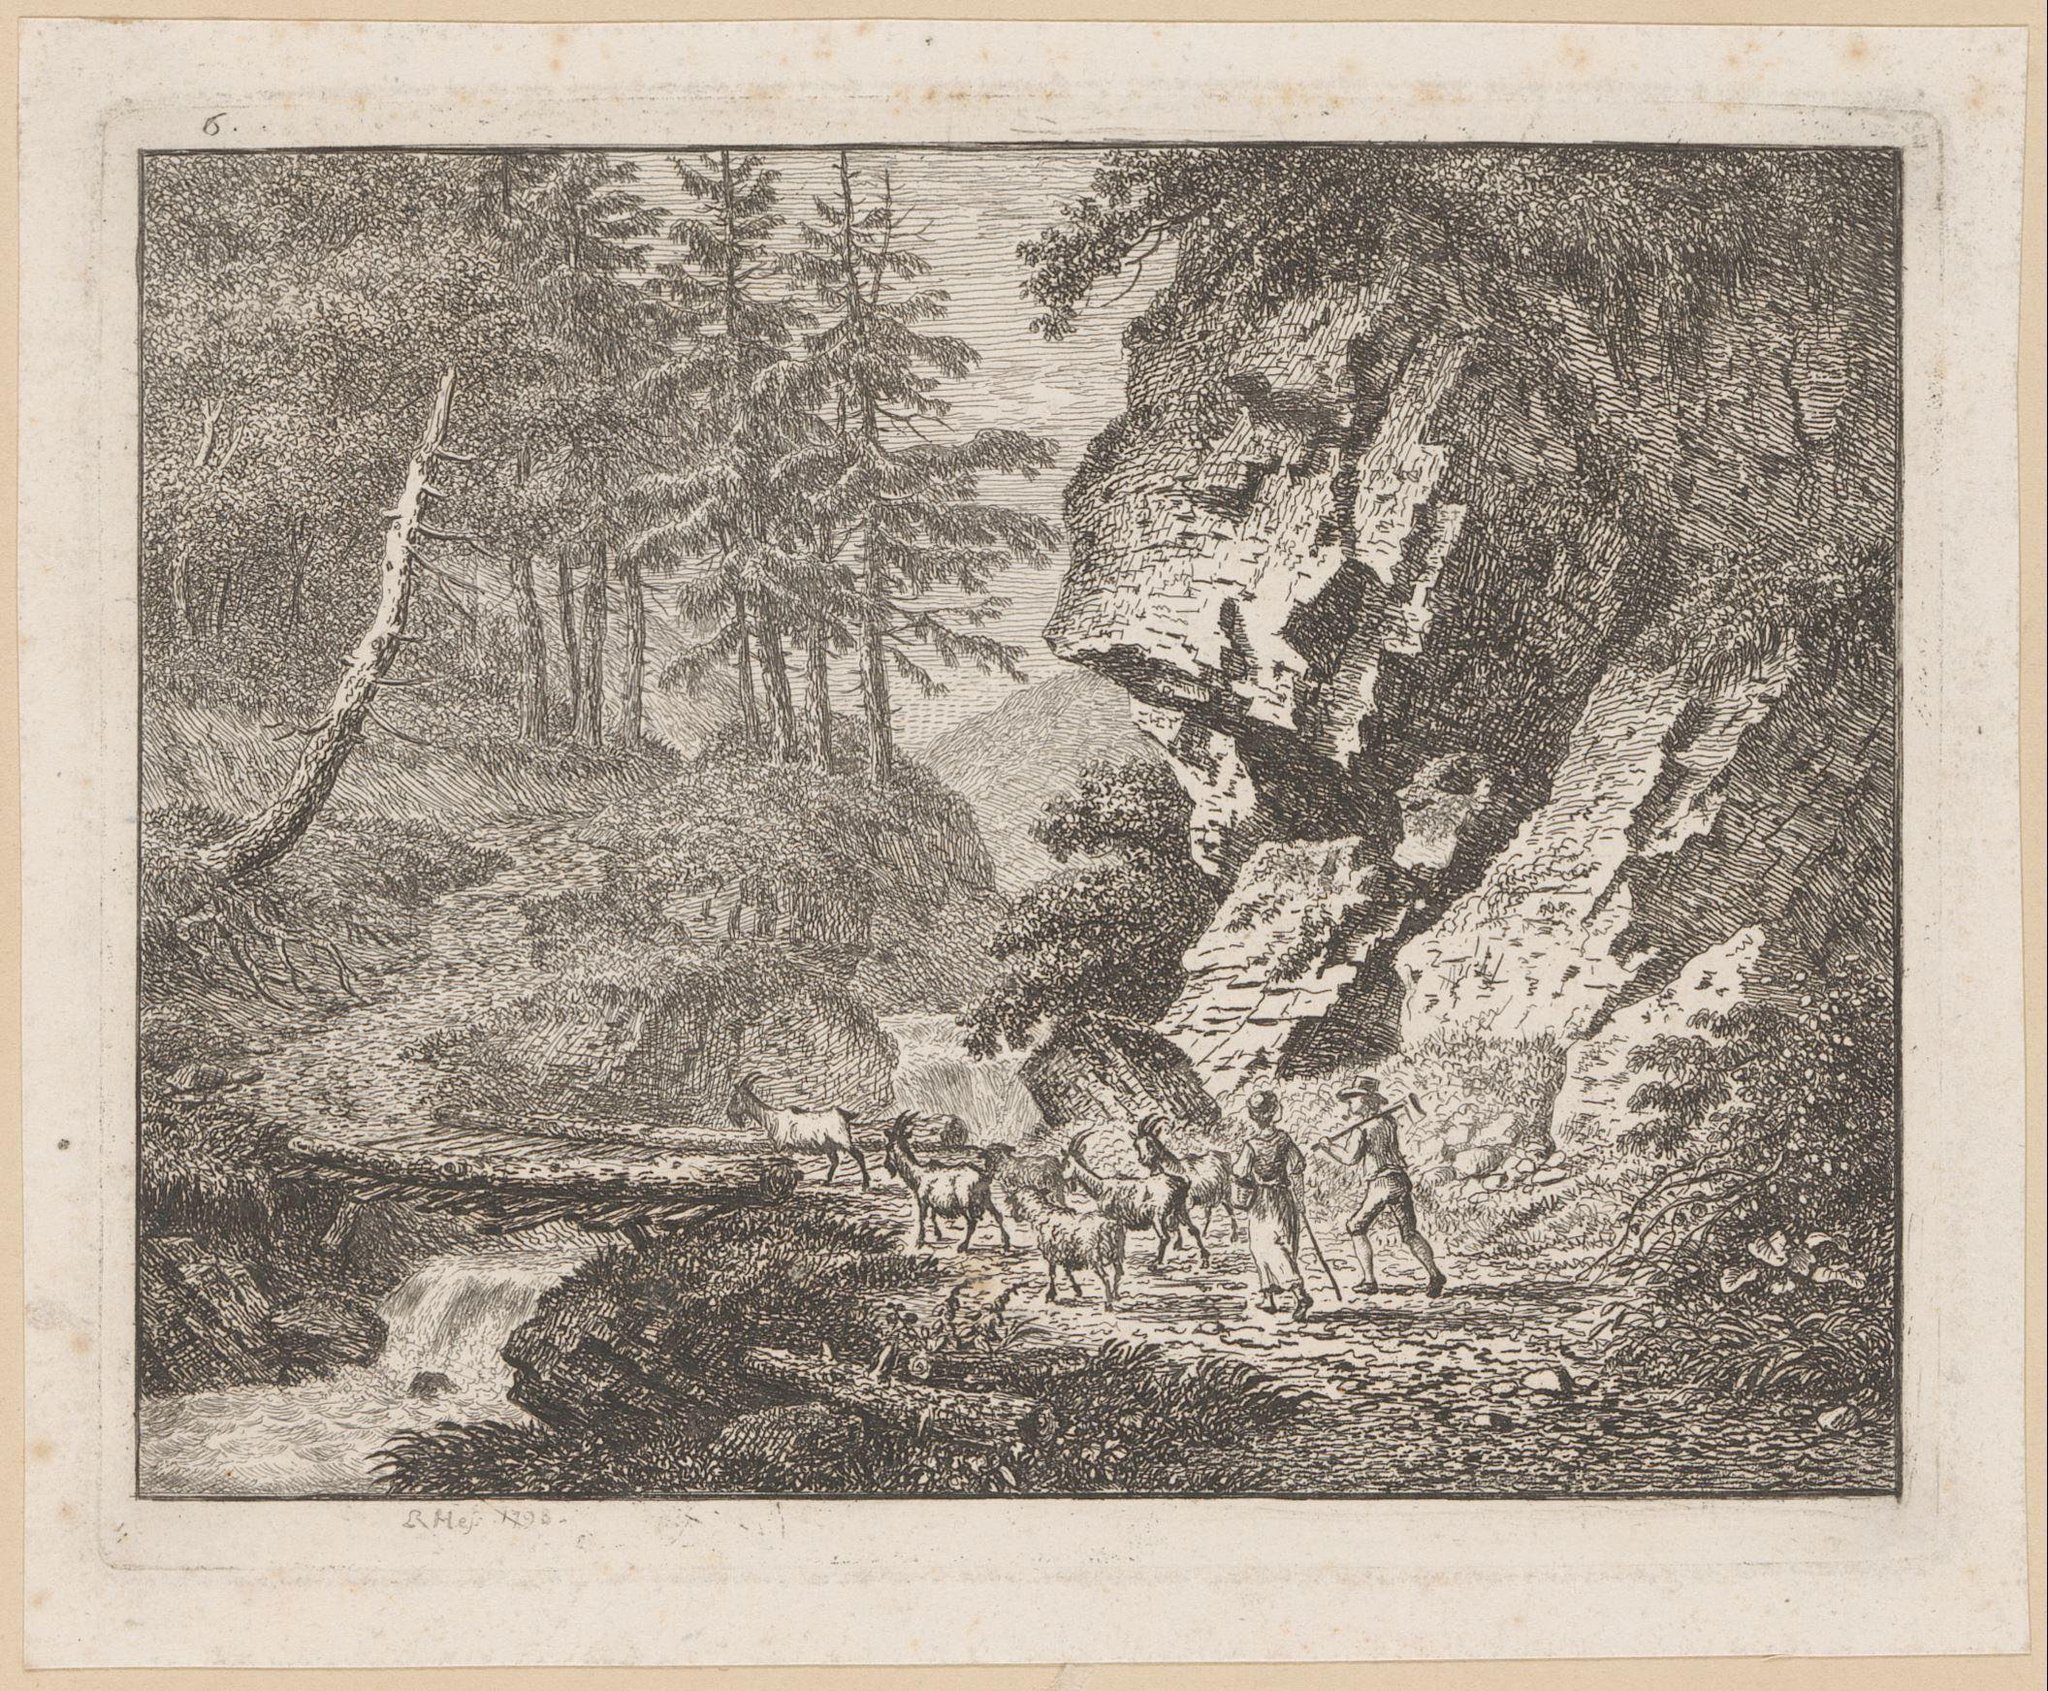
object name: print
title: Bergachtige landschappen met reizigers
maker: ludwig hess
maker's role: painter, print maker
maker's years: 1760-1800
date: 1798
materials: paper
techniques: etching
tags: landscapes with waters, waterscapes, seascapes (in the temperate zone), 'en route', traveller under way, mountains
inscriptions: collector's mark: Lugt 2228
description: Onderdeel van een serie van mogelijk tien prenten met bergachtige landschappen met reizigers. Prent nummer 10 in British Museum: 1878,0713.2123.